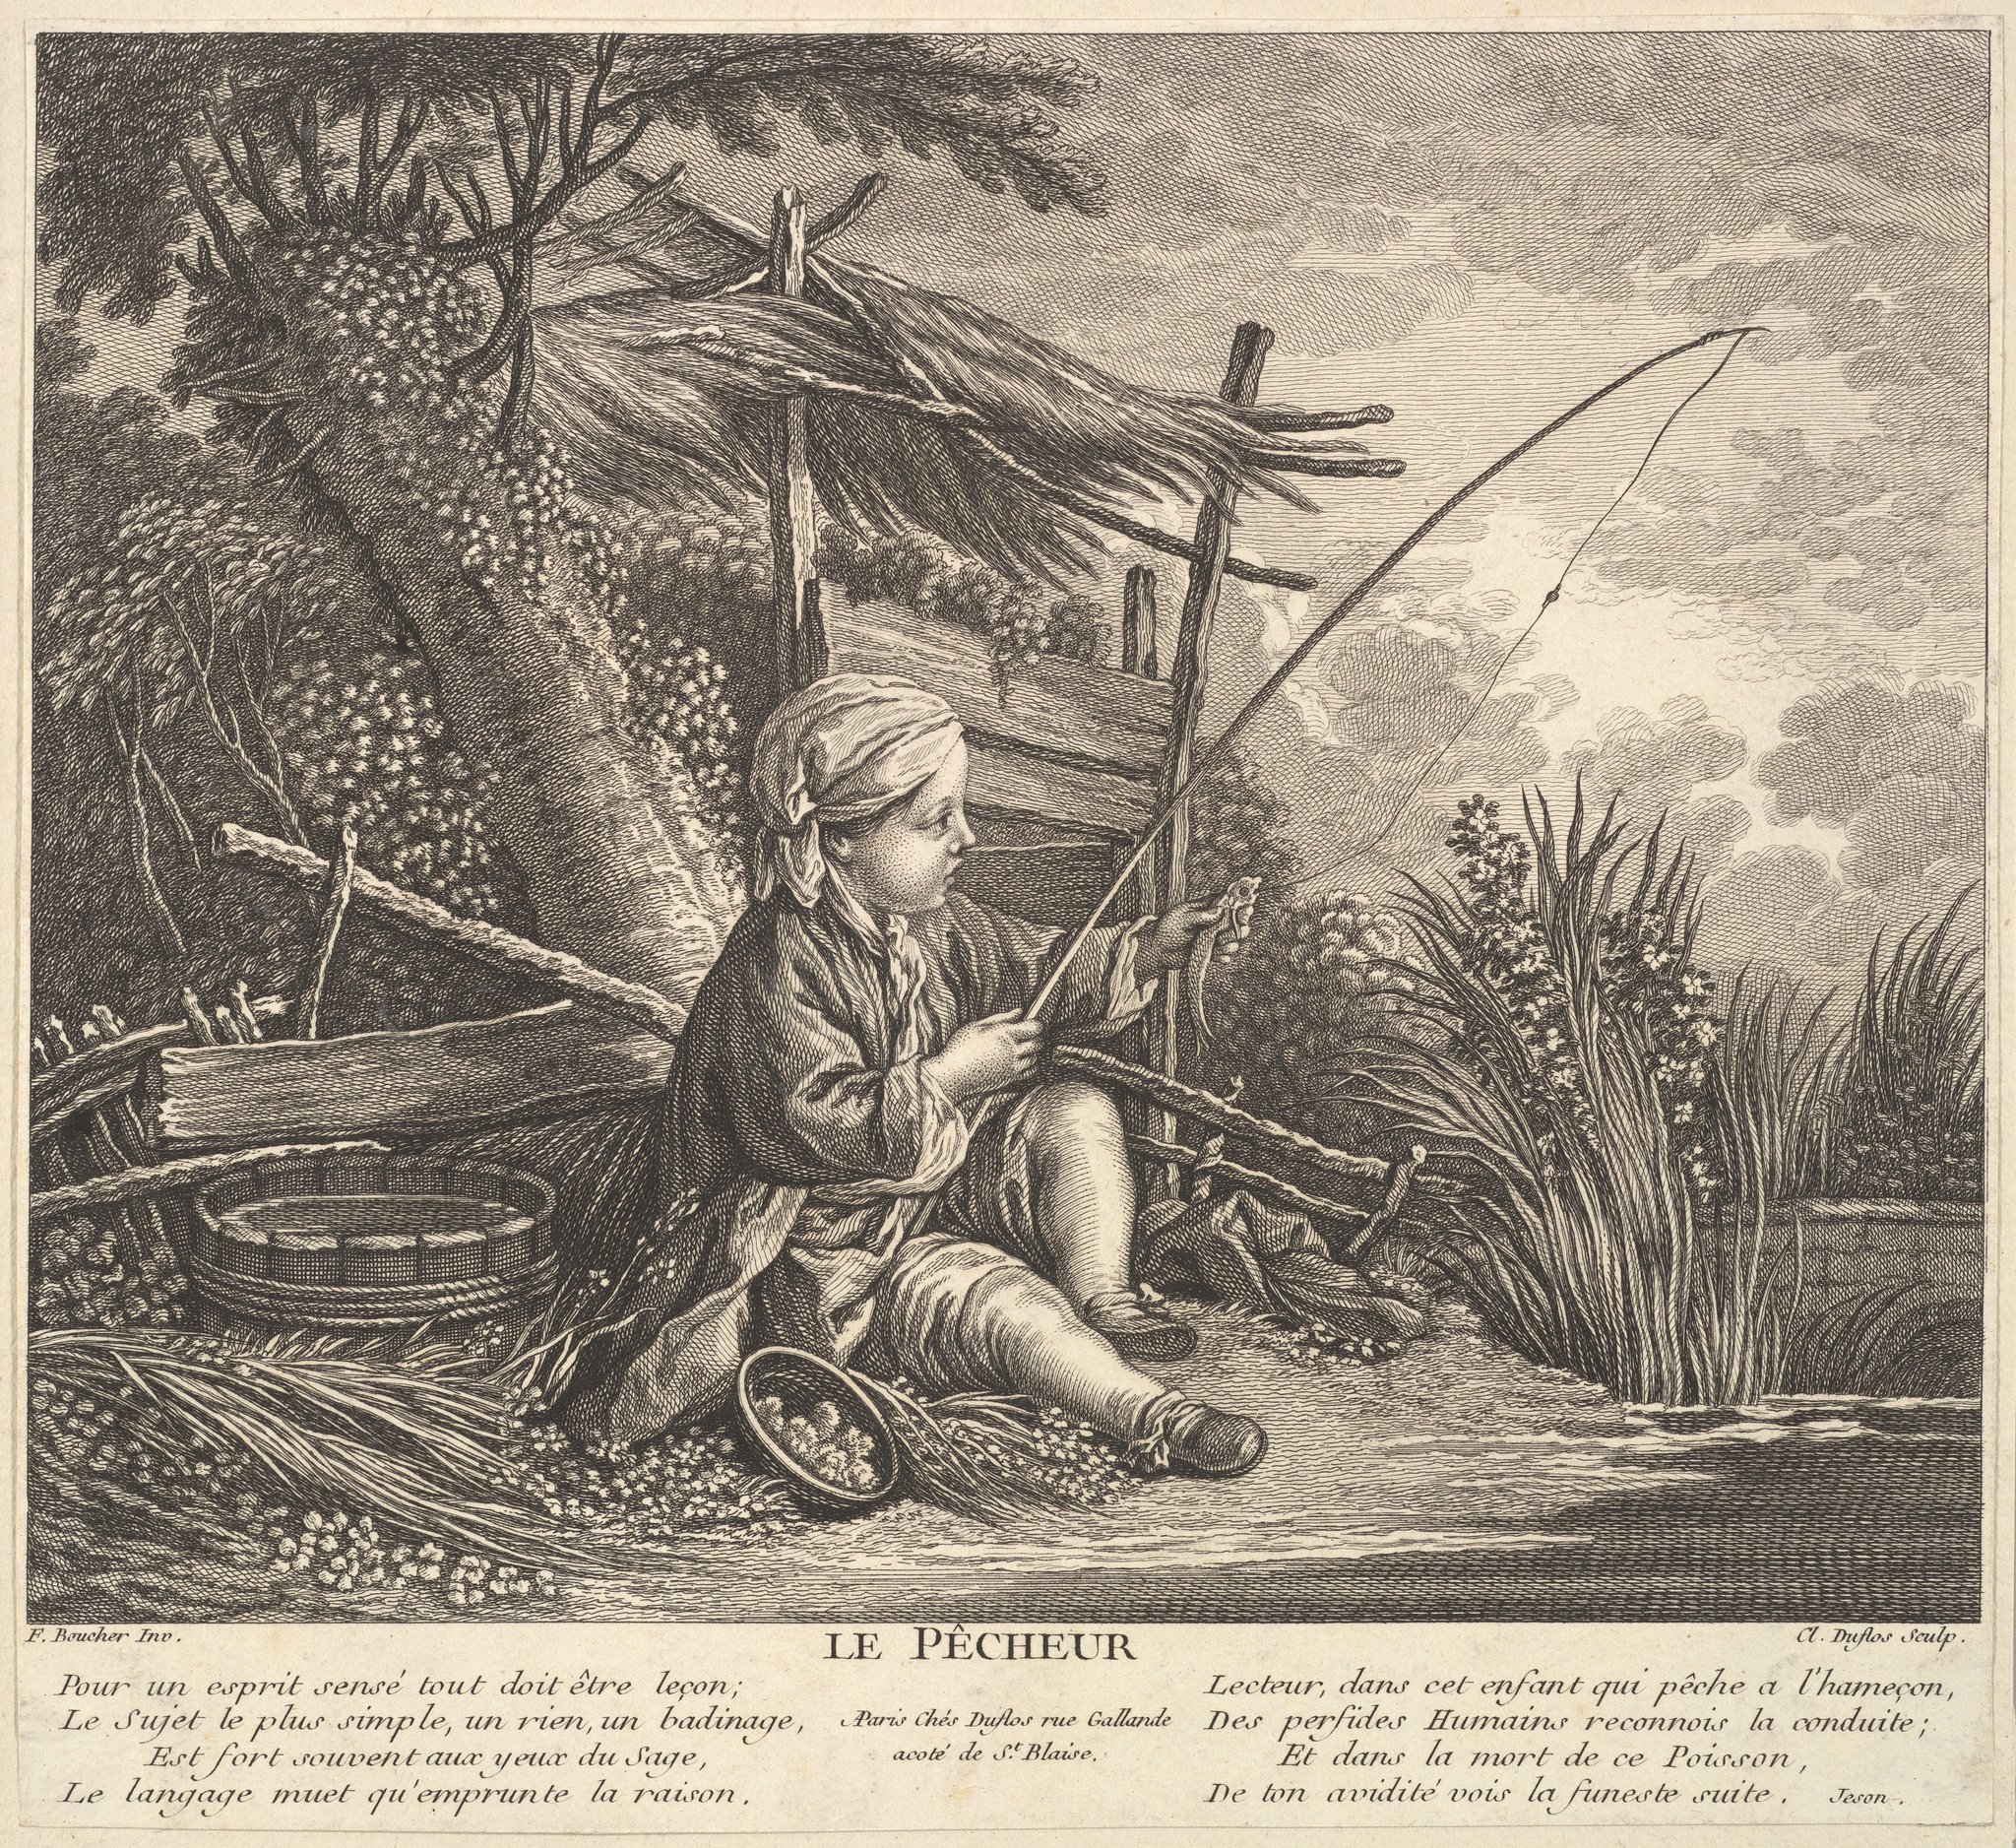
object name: print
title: Fisherman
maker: claude augustin duflos le jeune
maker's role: artist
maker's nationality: french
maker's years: 1700-1786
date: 1753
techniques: engraving, etching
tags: boys,fishing